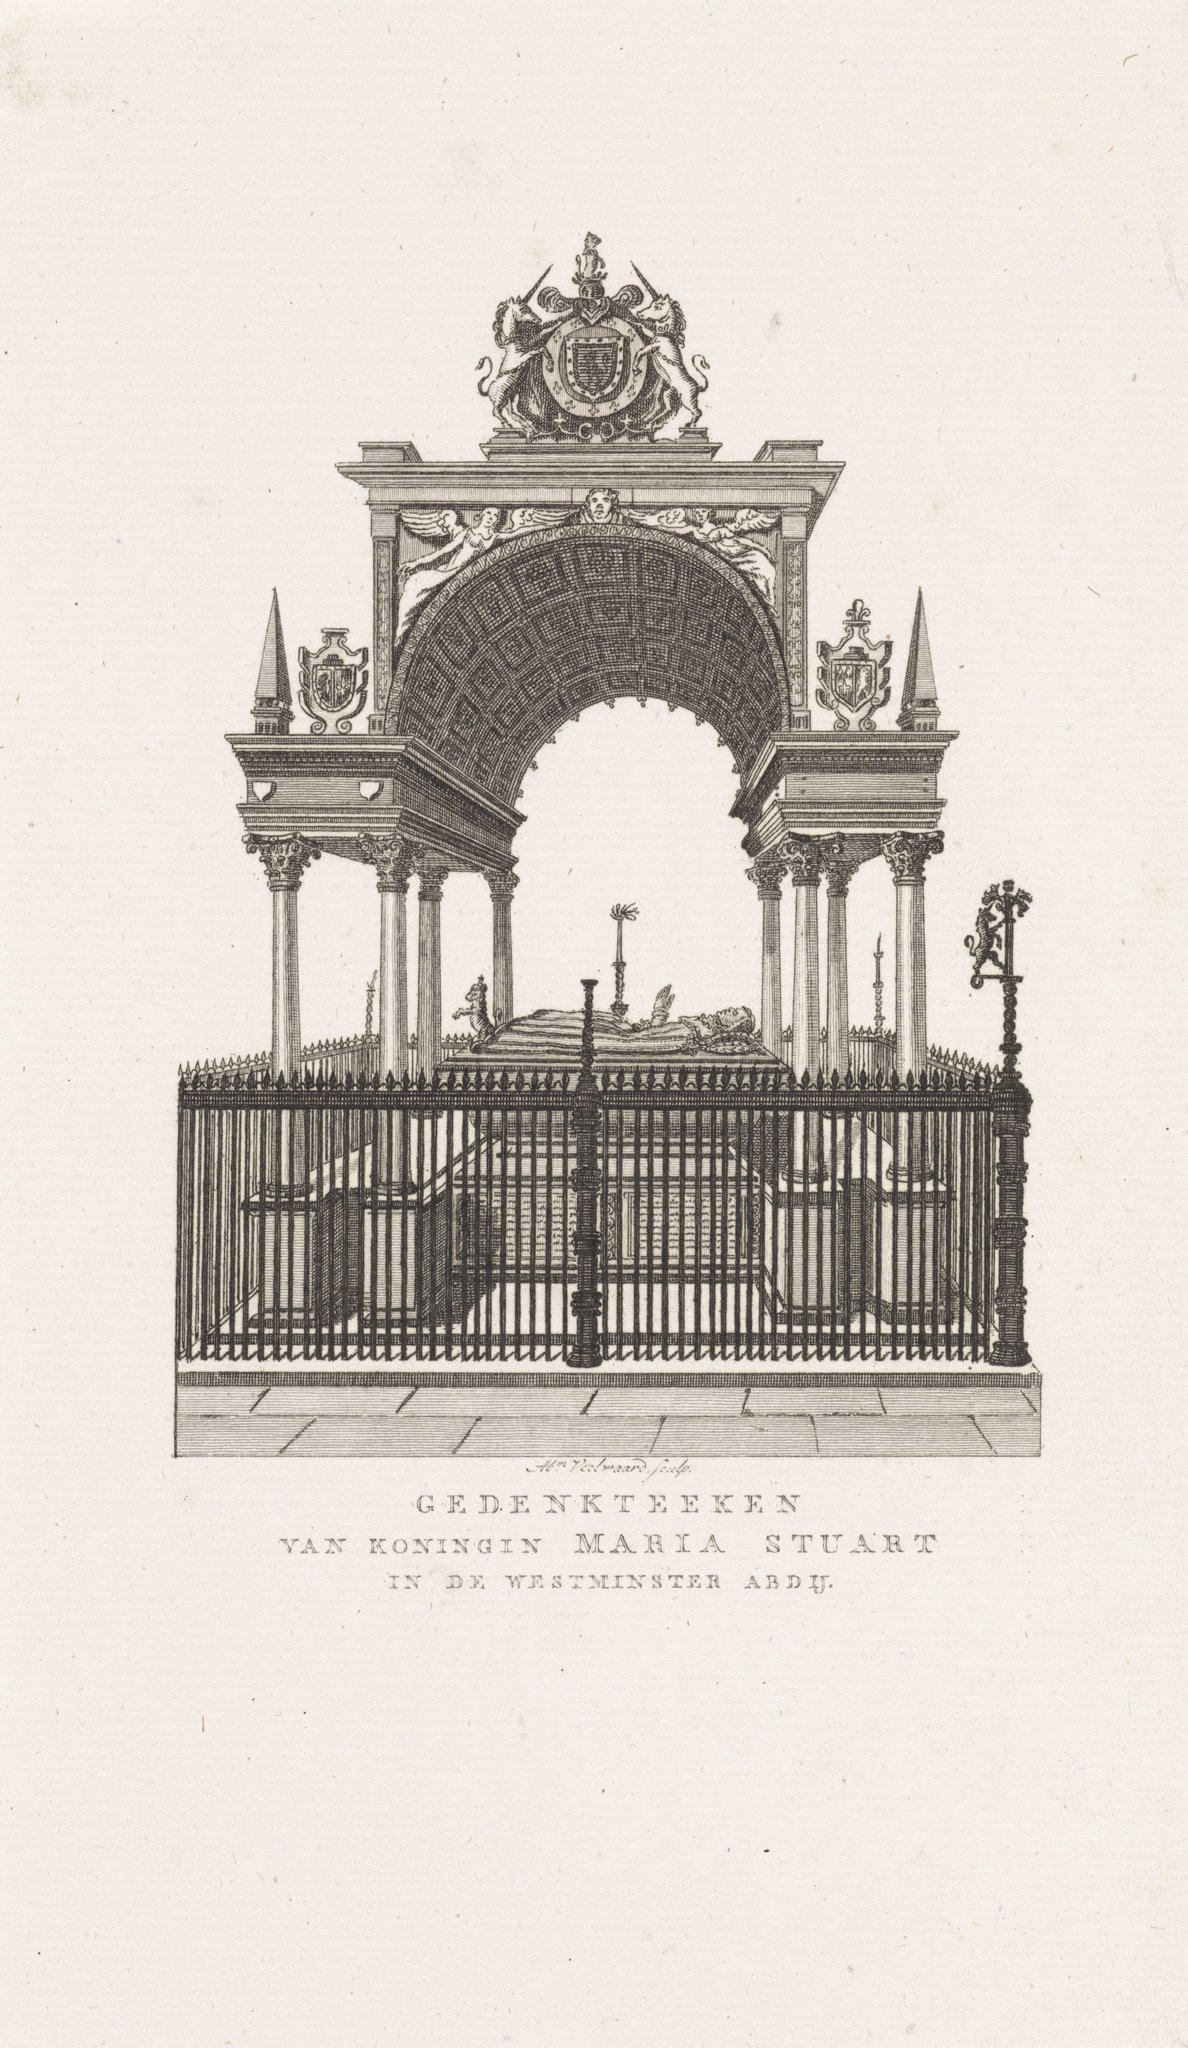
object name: print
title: Het gedenkteken van Maria Stuart in Westminster Abbey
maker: abraham veelwaard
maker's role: print maker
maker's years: 1792-1873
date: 1802-1873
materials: paper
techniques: engraving, etching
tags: london, maria ii stuart (koningin van engeland, schotland en ierland), grave-building, monumental tomb, westminster abbey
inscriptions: collector's mark: Lugt 2228